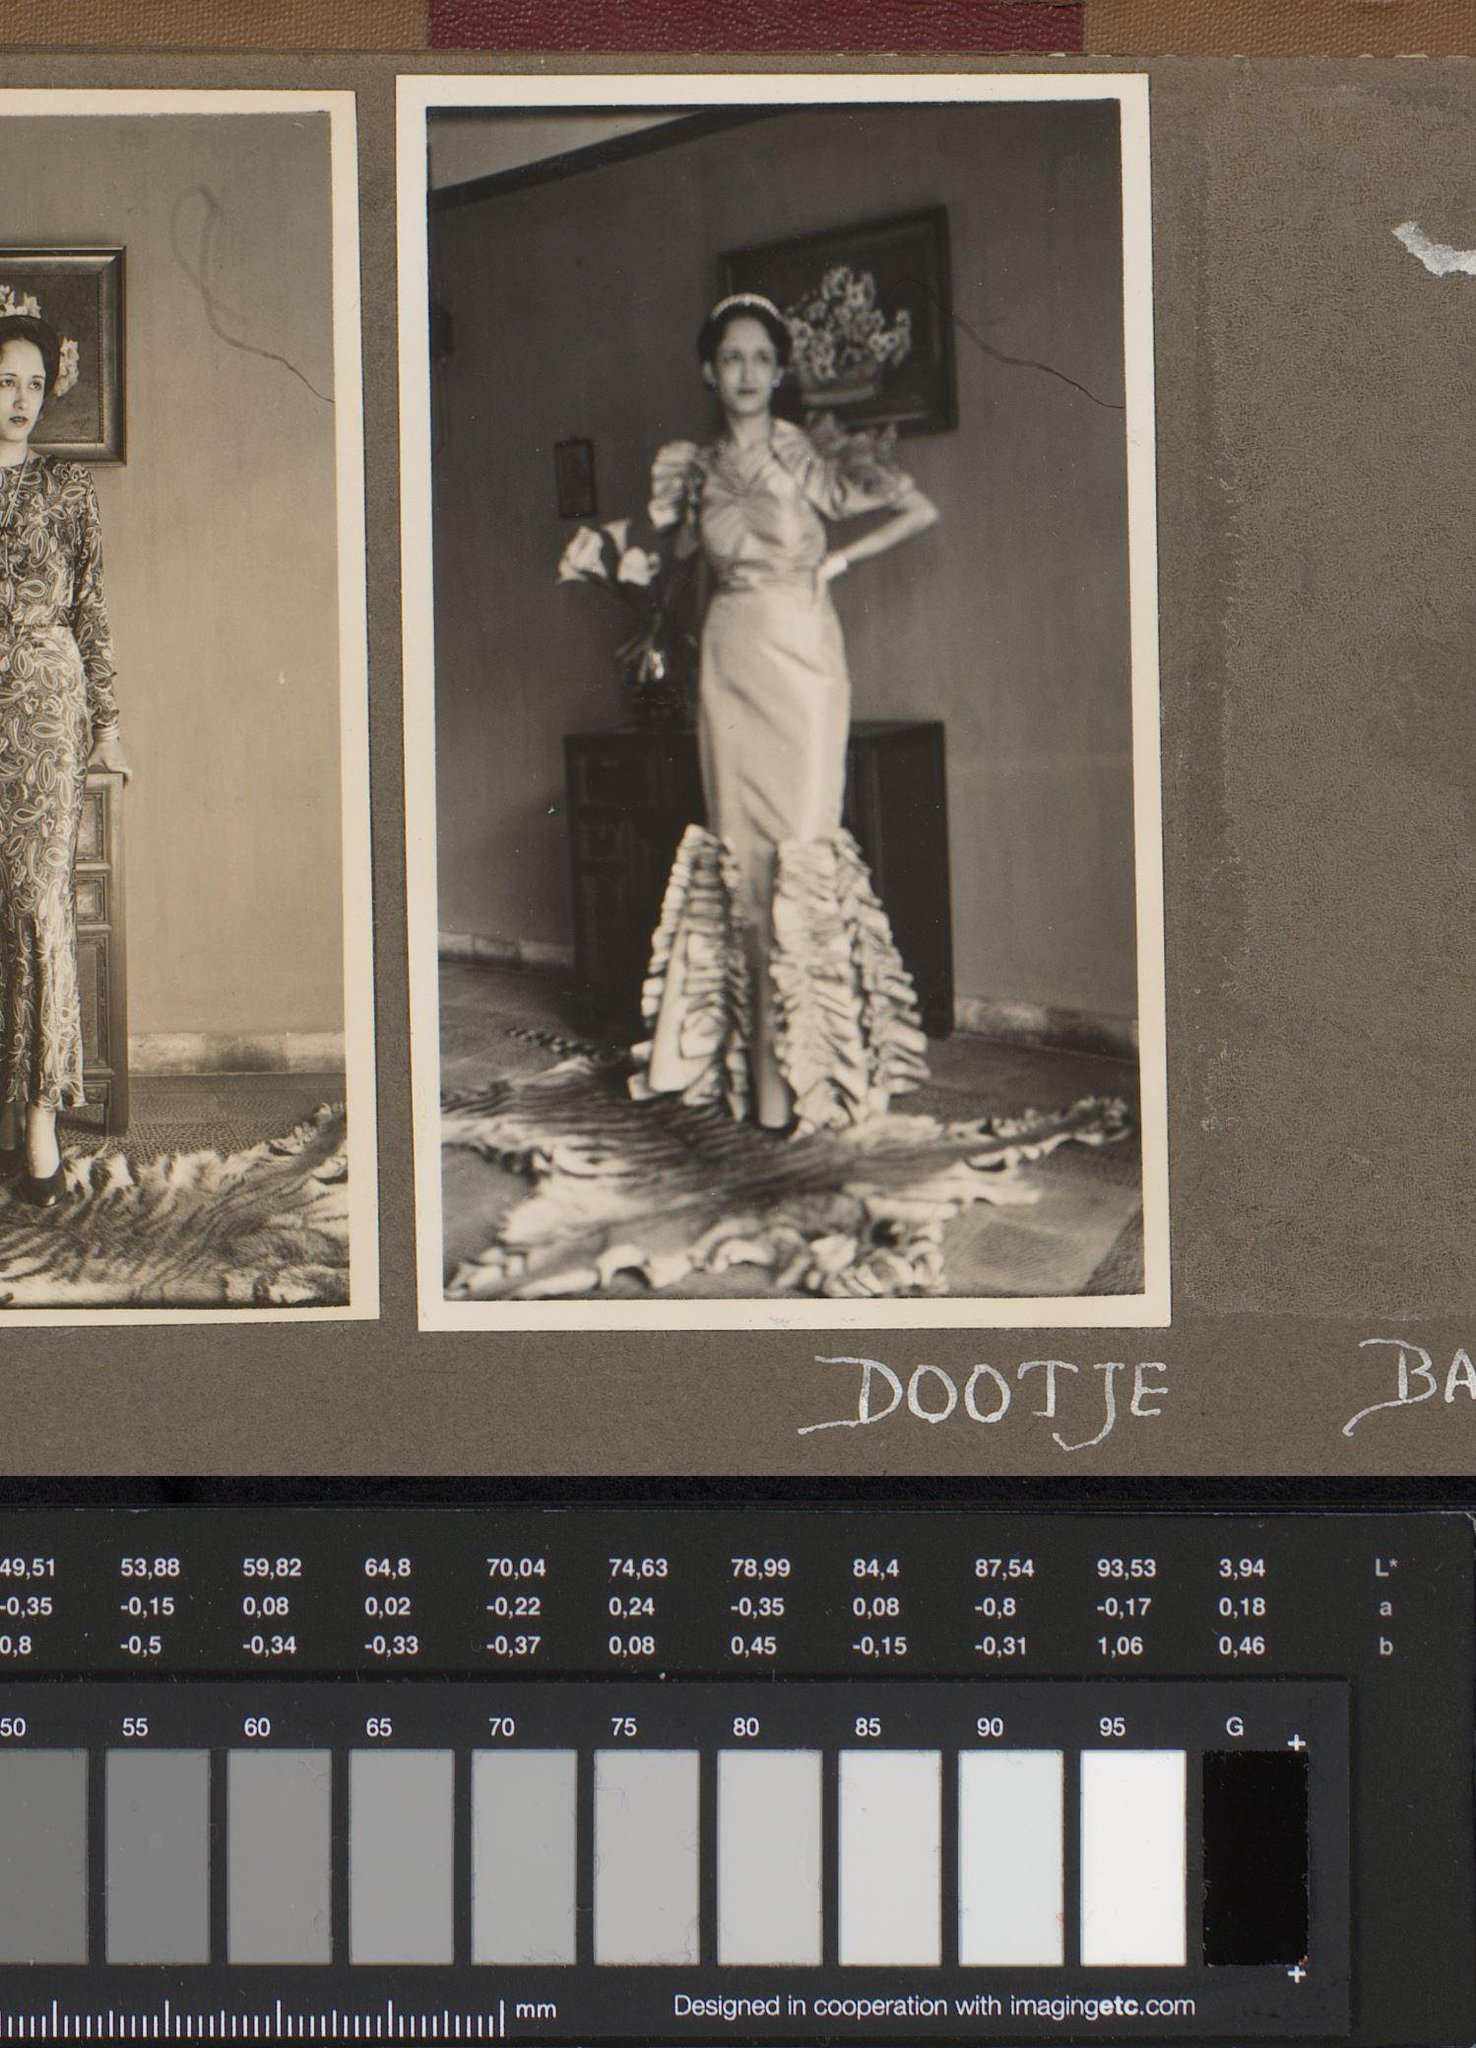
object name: album leaf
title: Portret van Dootje in een woonkamer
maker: Anonymous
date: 1934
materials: paper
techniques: gelatin silver print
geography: batavia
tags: amsterdam, historical persons - bb - woman, cupboard, batavia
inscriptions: inscription: ‘Dootje Batavia 1934’